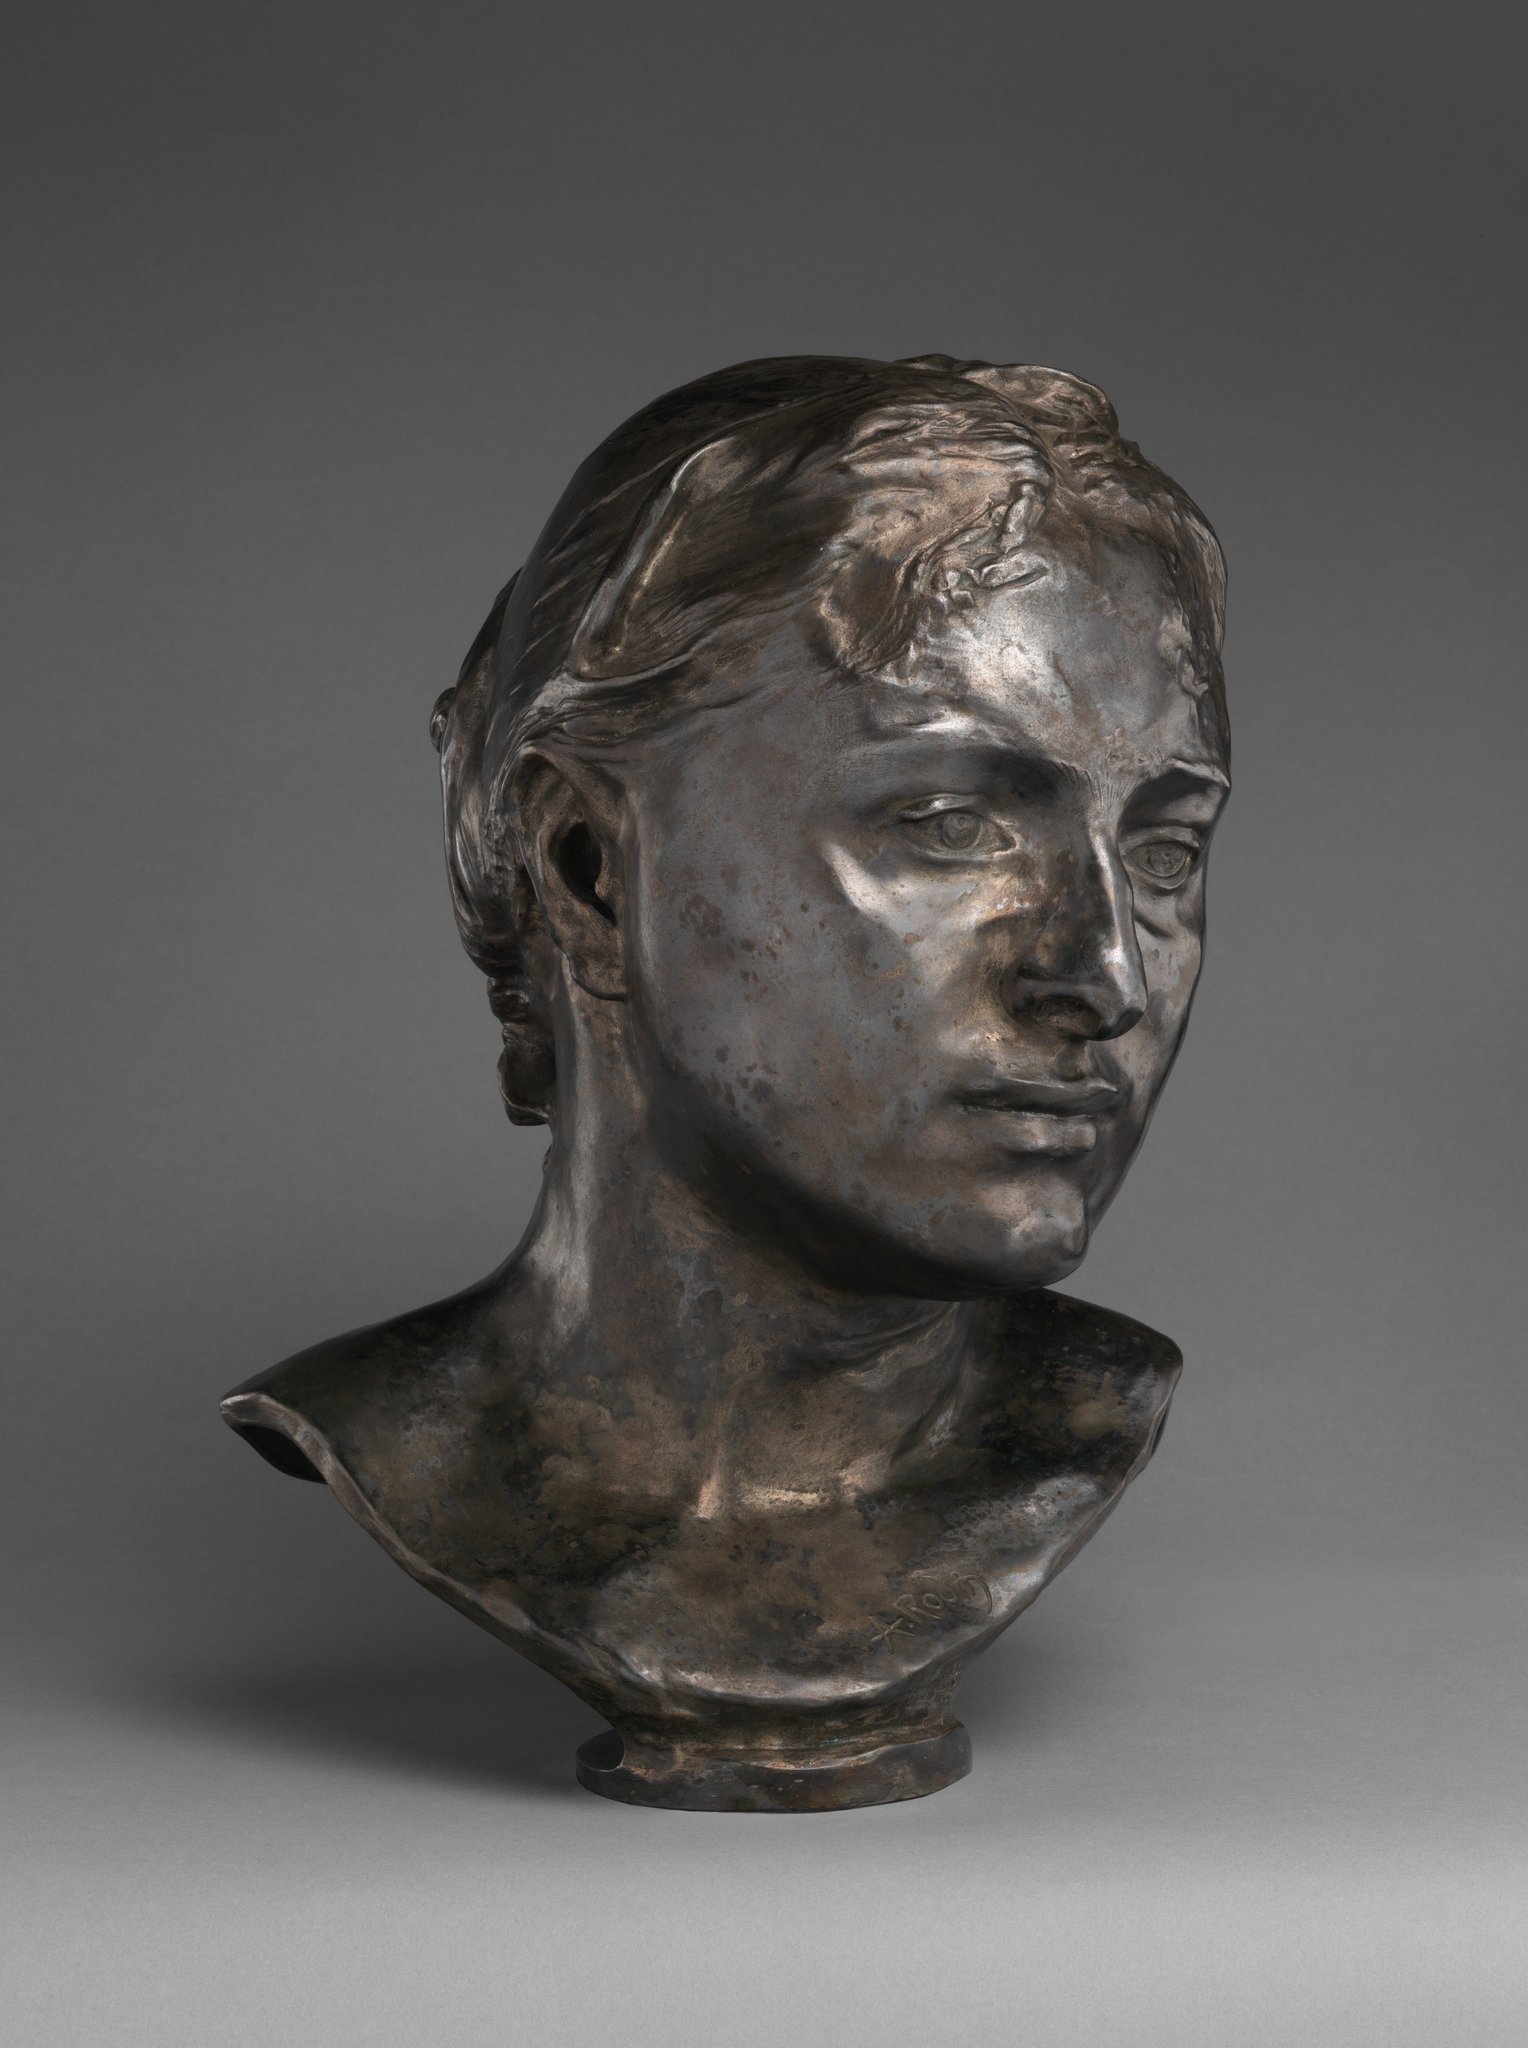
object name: bust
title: Mrs. Russell (Mariana Mattioco della Torre)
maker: auguste rodin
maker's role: artist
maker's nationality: french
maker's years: 1840-1917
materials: bronze, marble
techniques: silvered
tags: portraits,women